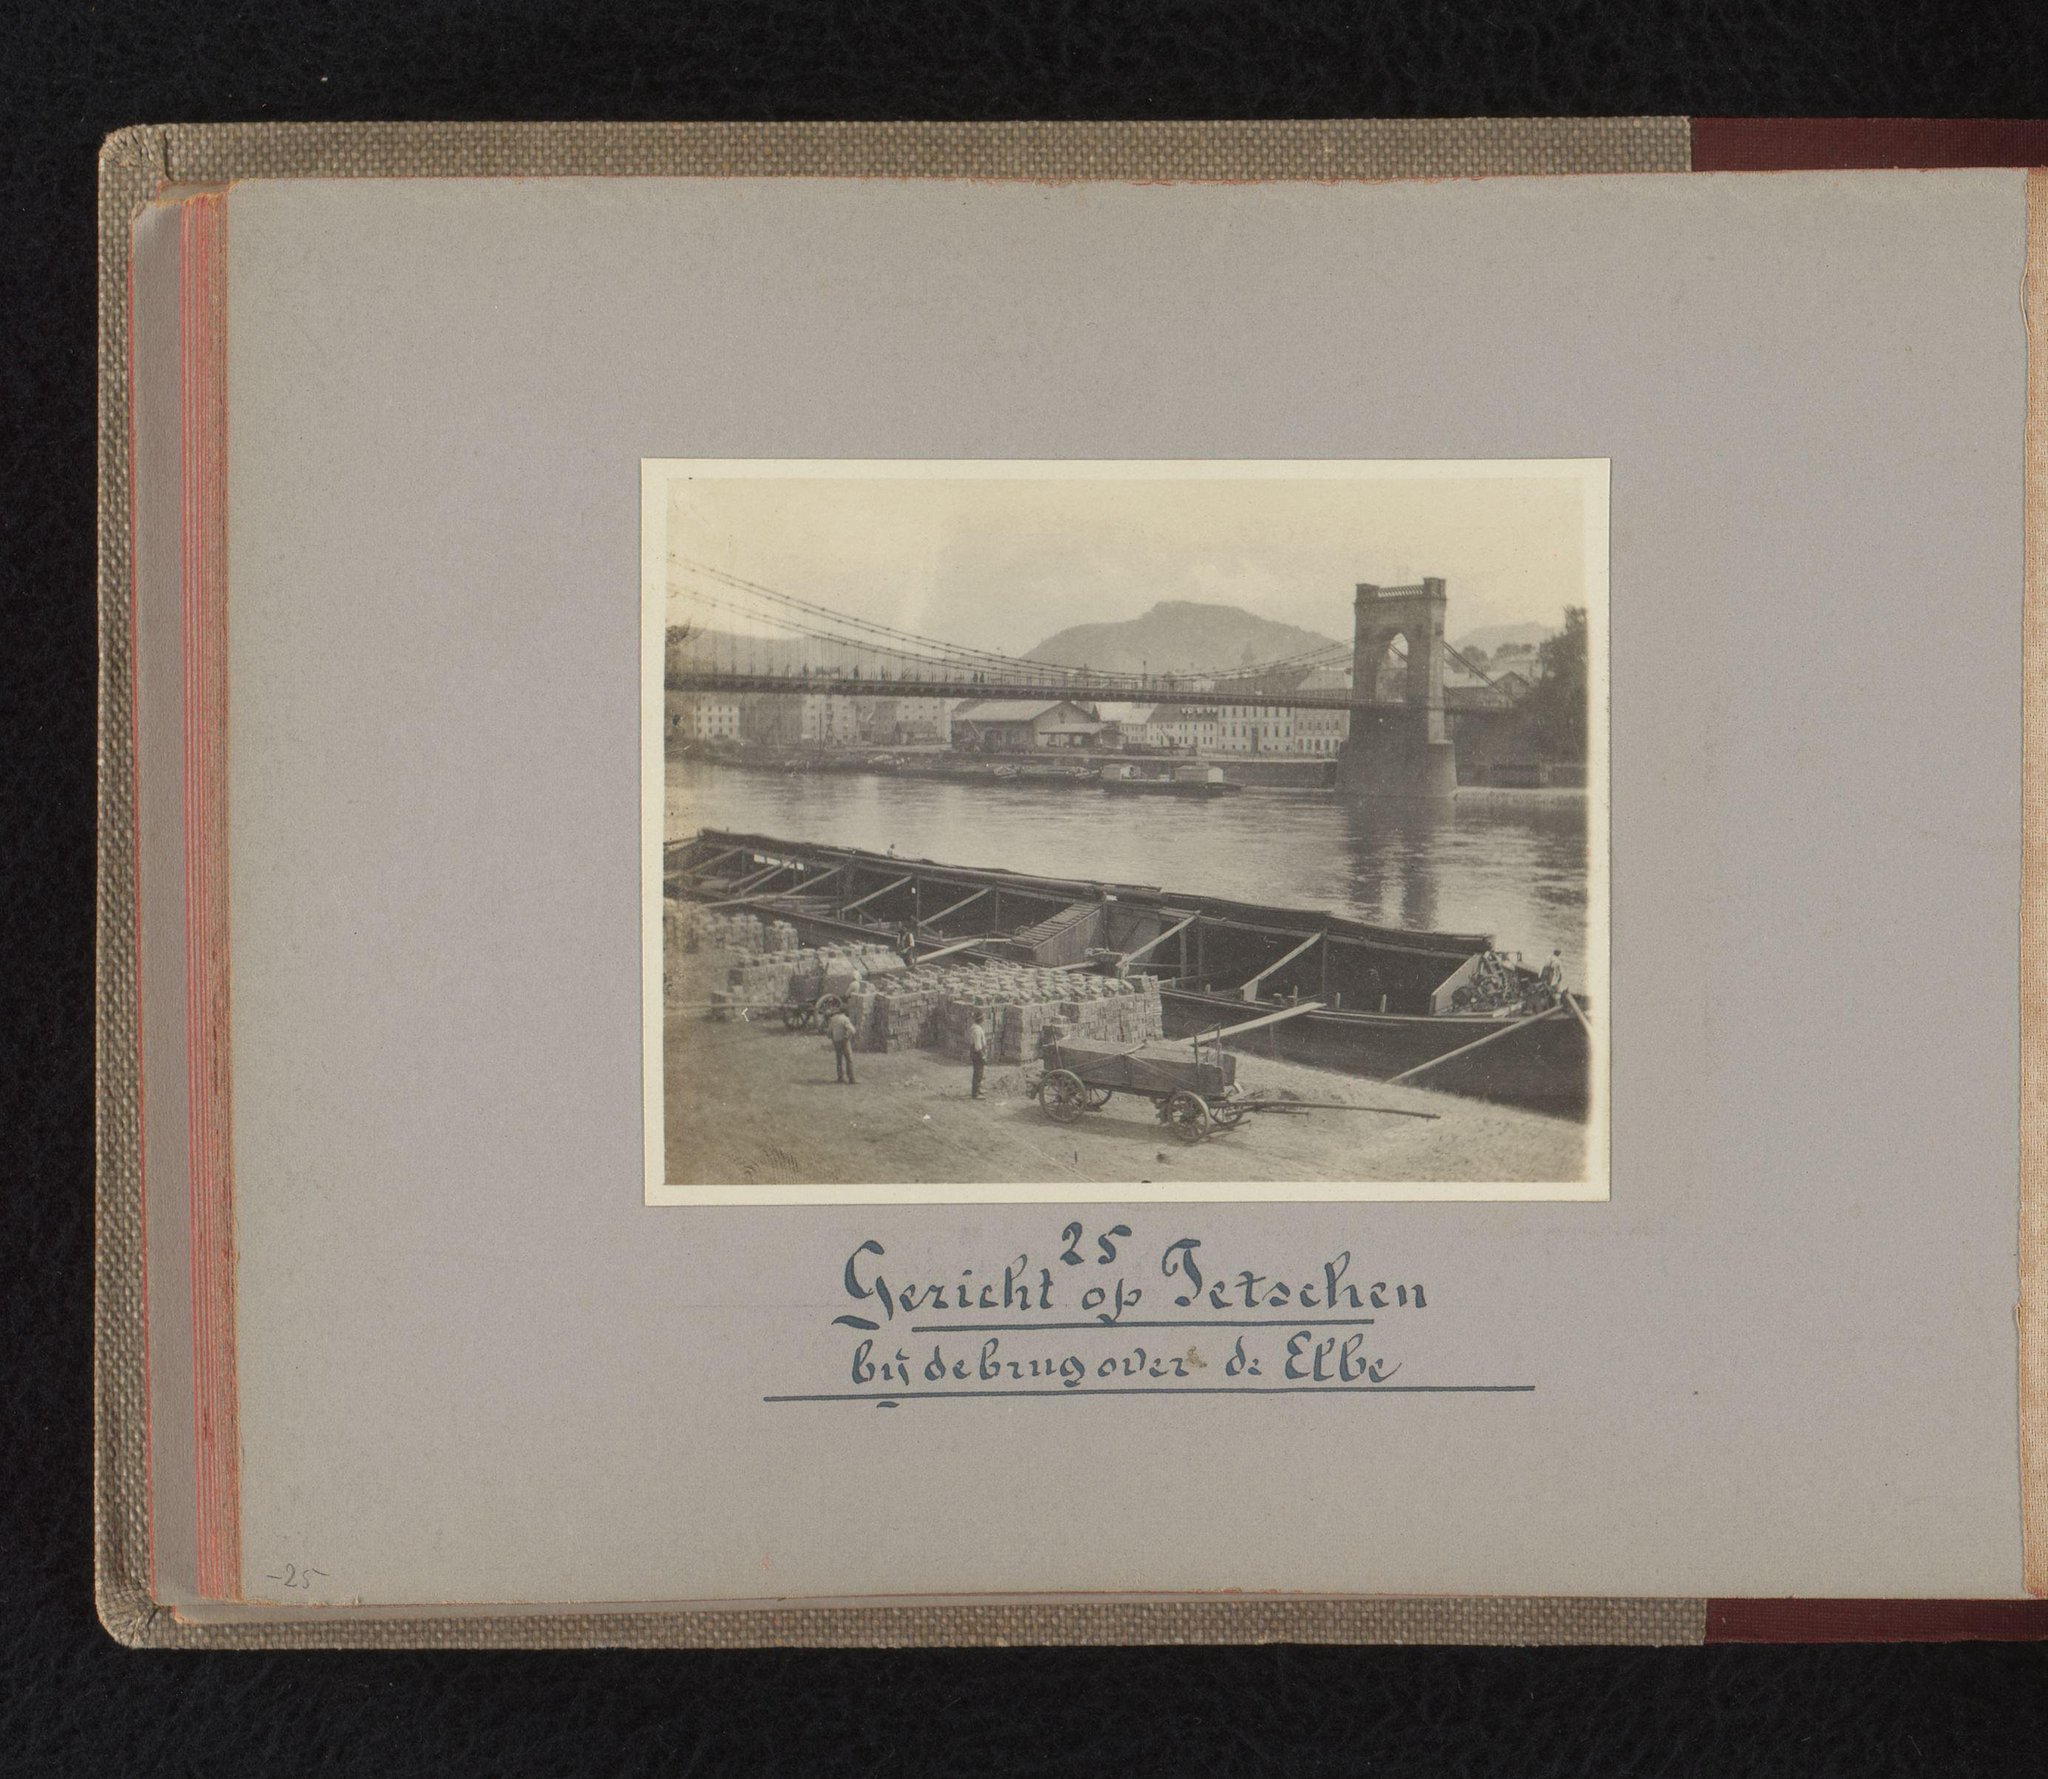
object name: album leaf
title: Gezicht op Tetschen bij de brug over de Elbe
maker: johan herman kessler (jan)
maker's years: 1892-1978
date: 1910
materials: paper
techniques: gelatin silver print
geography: decín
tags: city-view in general; 'veduta', bridge in city across river, canal, etc.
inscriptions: number: ‘25’